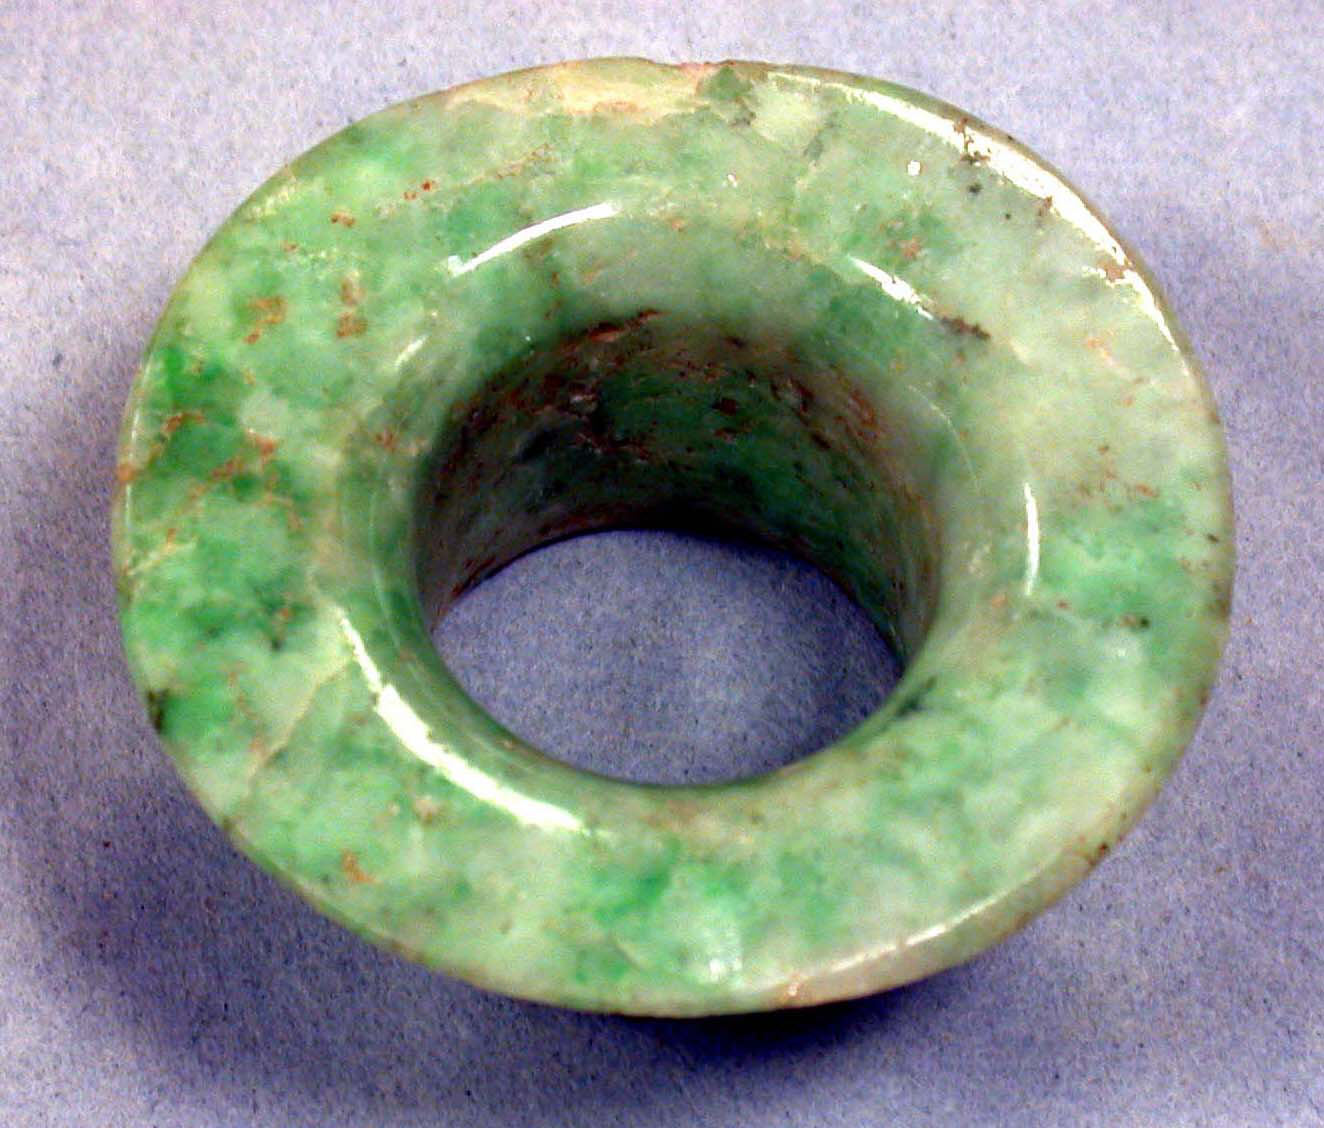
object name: earflare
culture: mexican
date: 1501-1600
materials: jade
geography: mexico